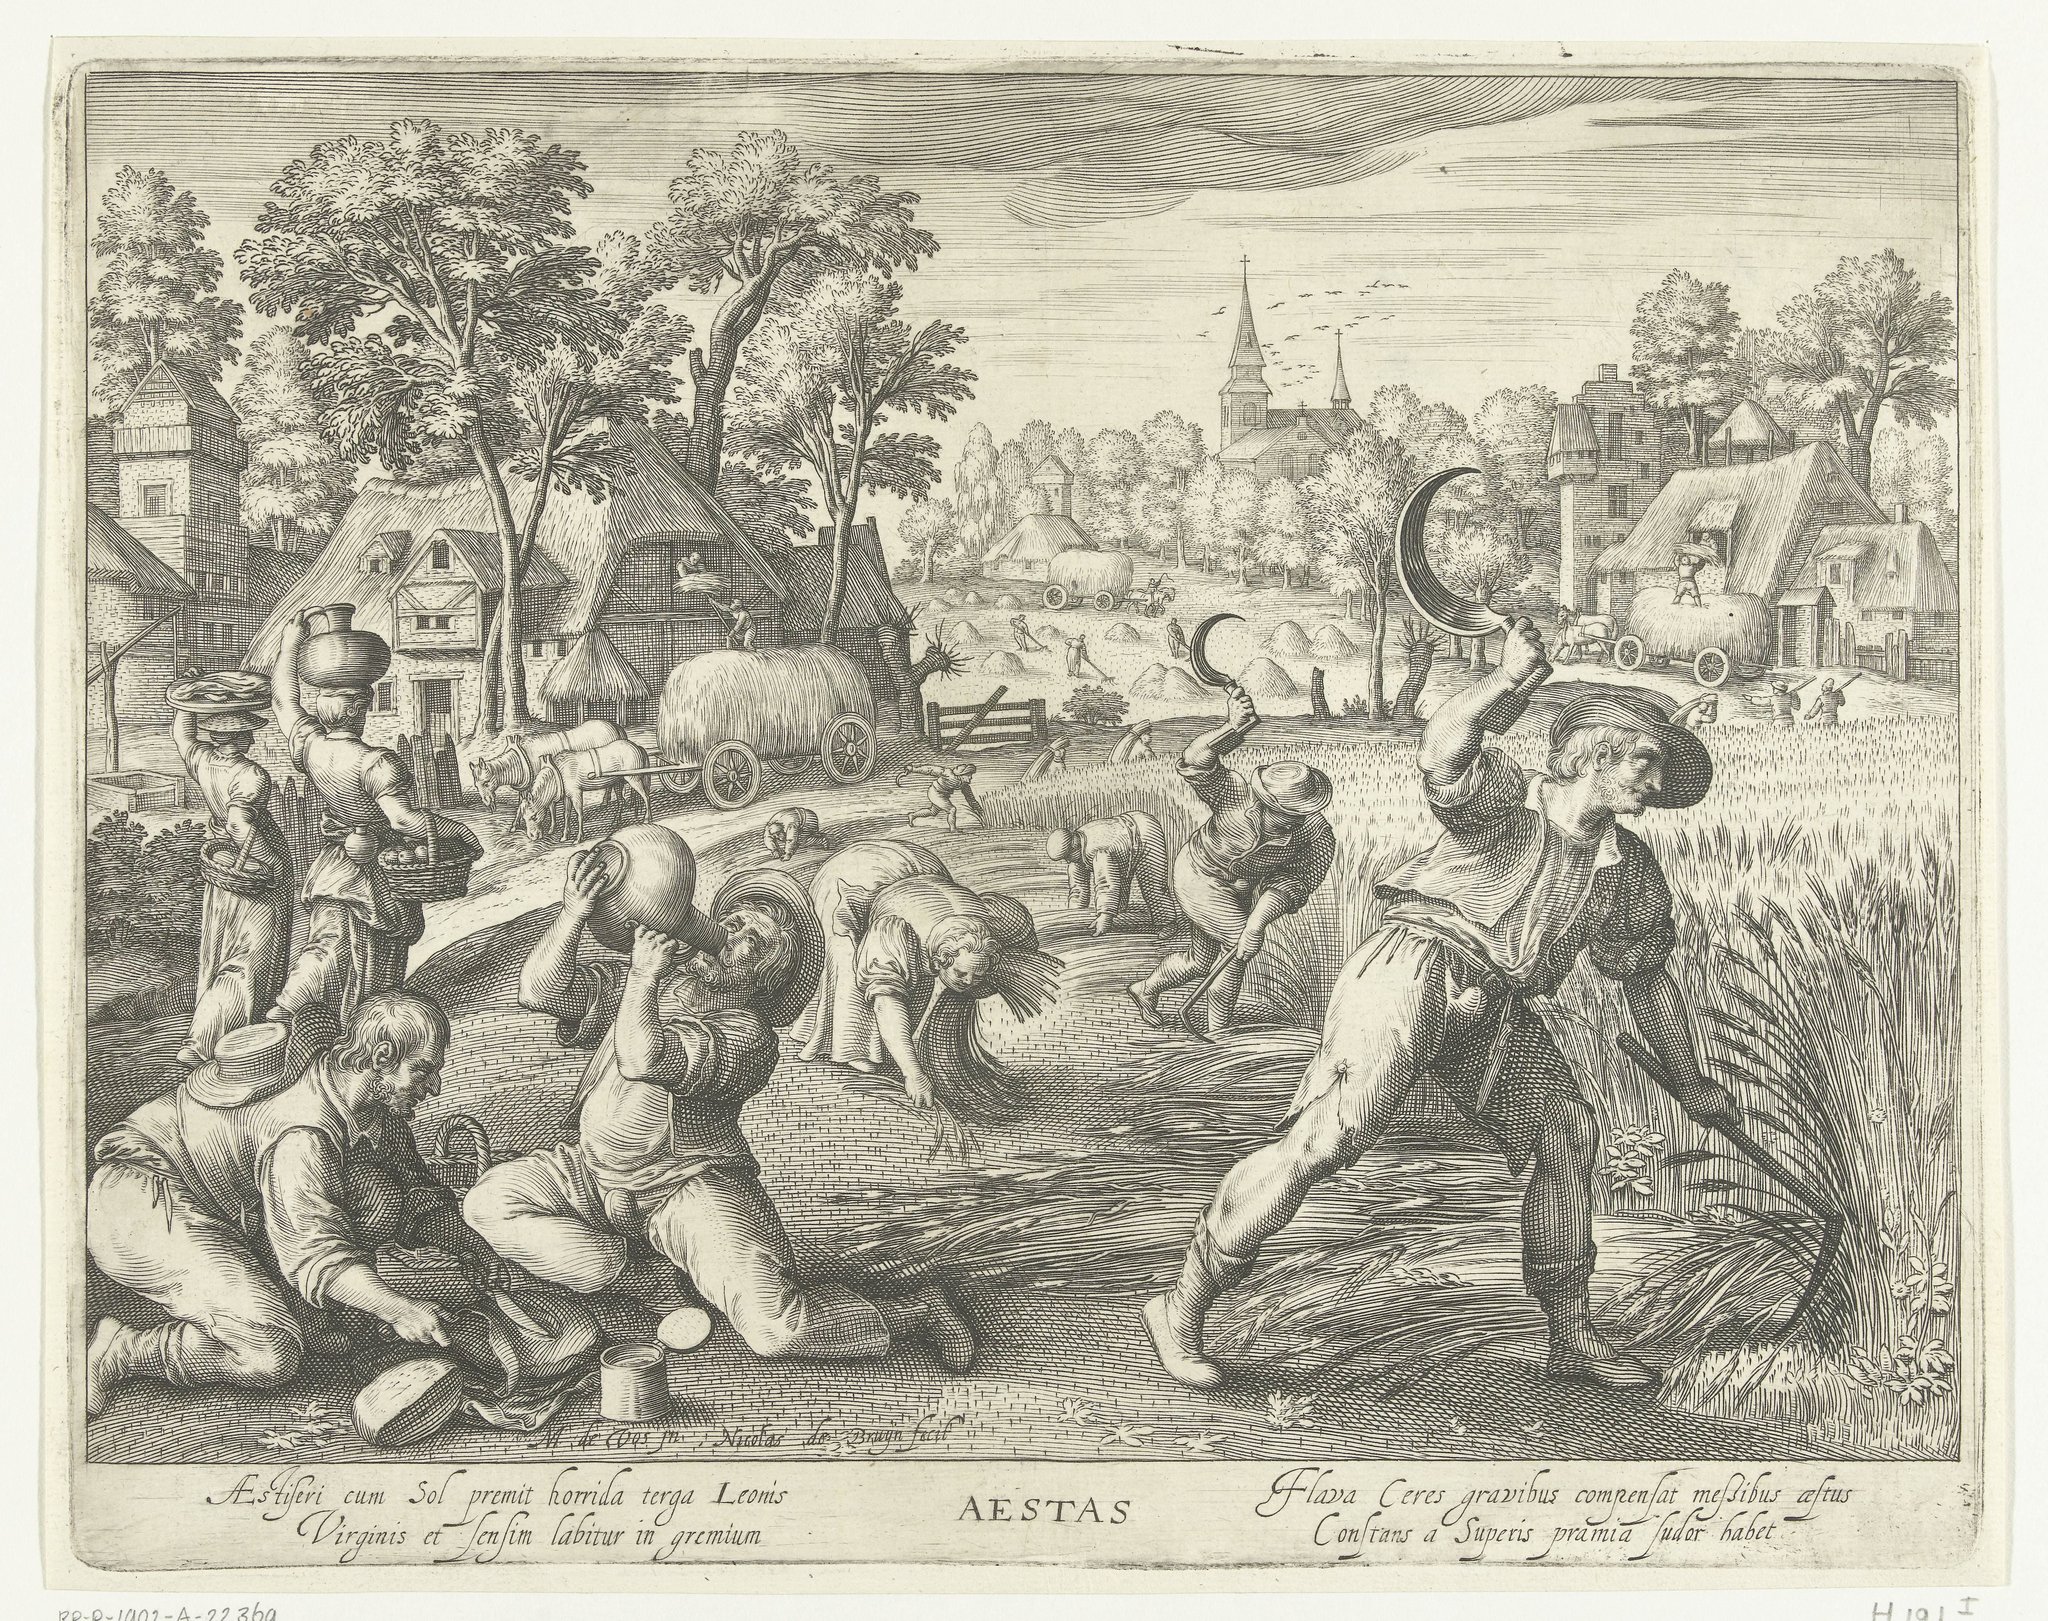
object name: print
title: Aestas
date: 1581-1656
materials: paper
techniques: engraving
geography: netherlands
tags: summer ~ human activities (the four seasons of the year)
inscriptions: collector's mark: Lugt 2542, collector's mark: Lugt 2228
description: Landschap met activiteiten die plaats vinden in de zomer: mannen oogsten graan en het hooi wordt op hooizolders opgeslagen. Onder in de marge staat een vers van vier regels in Latijn.